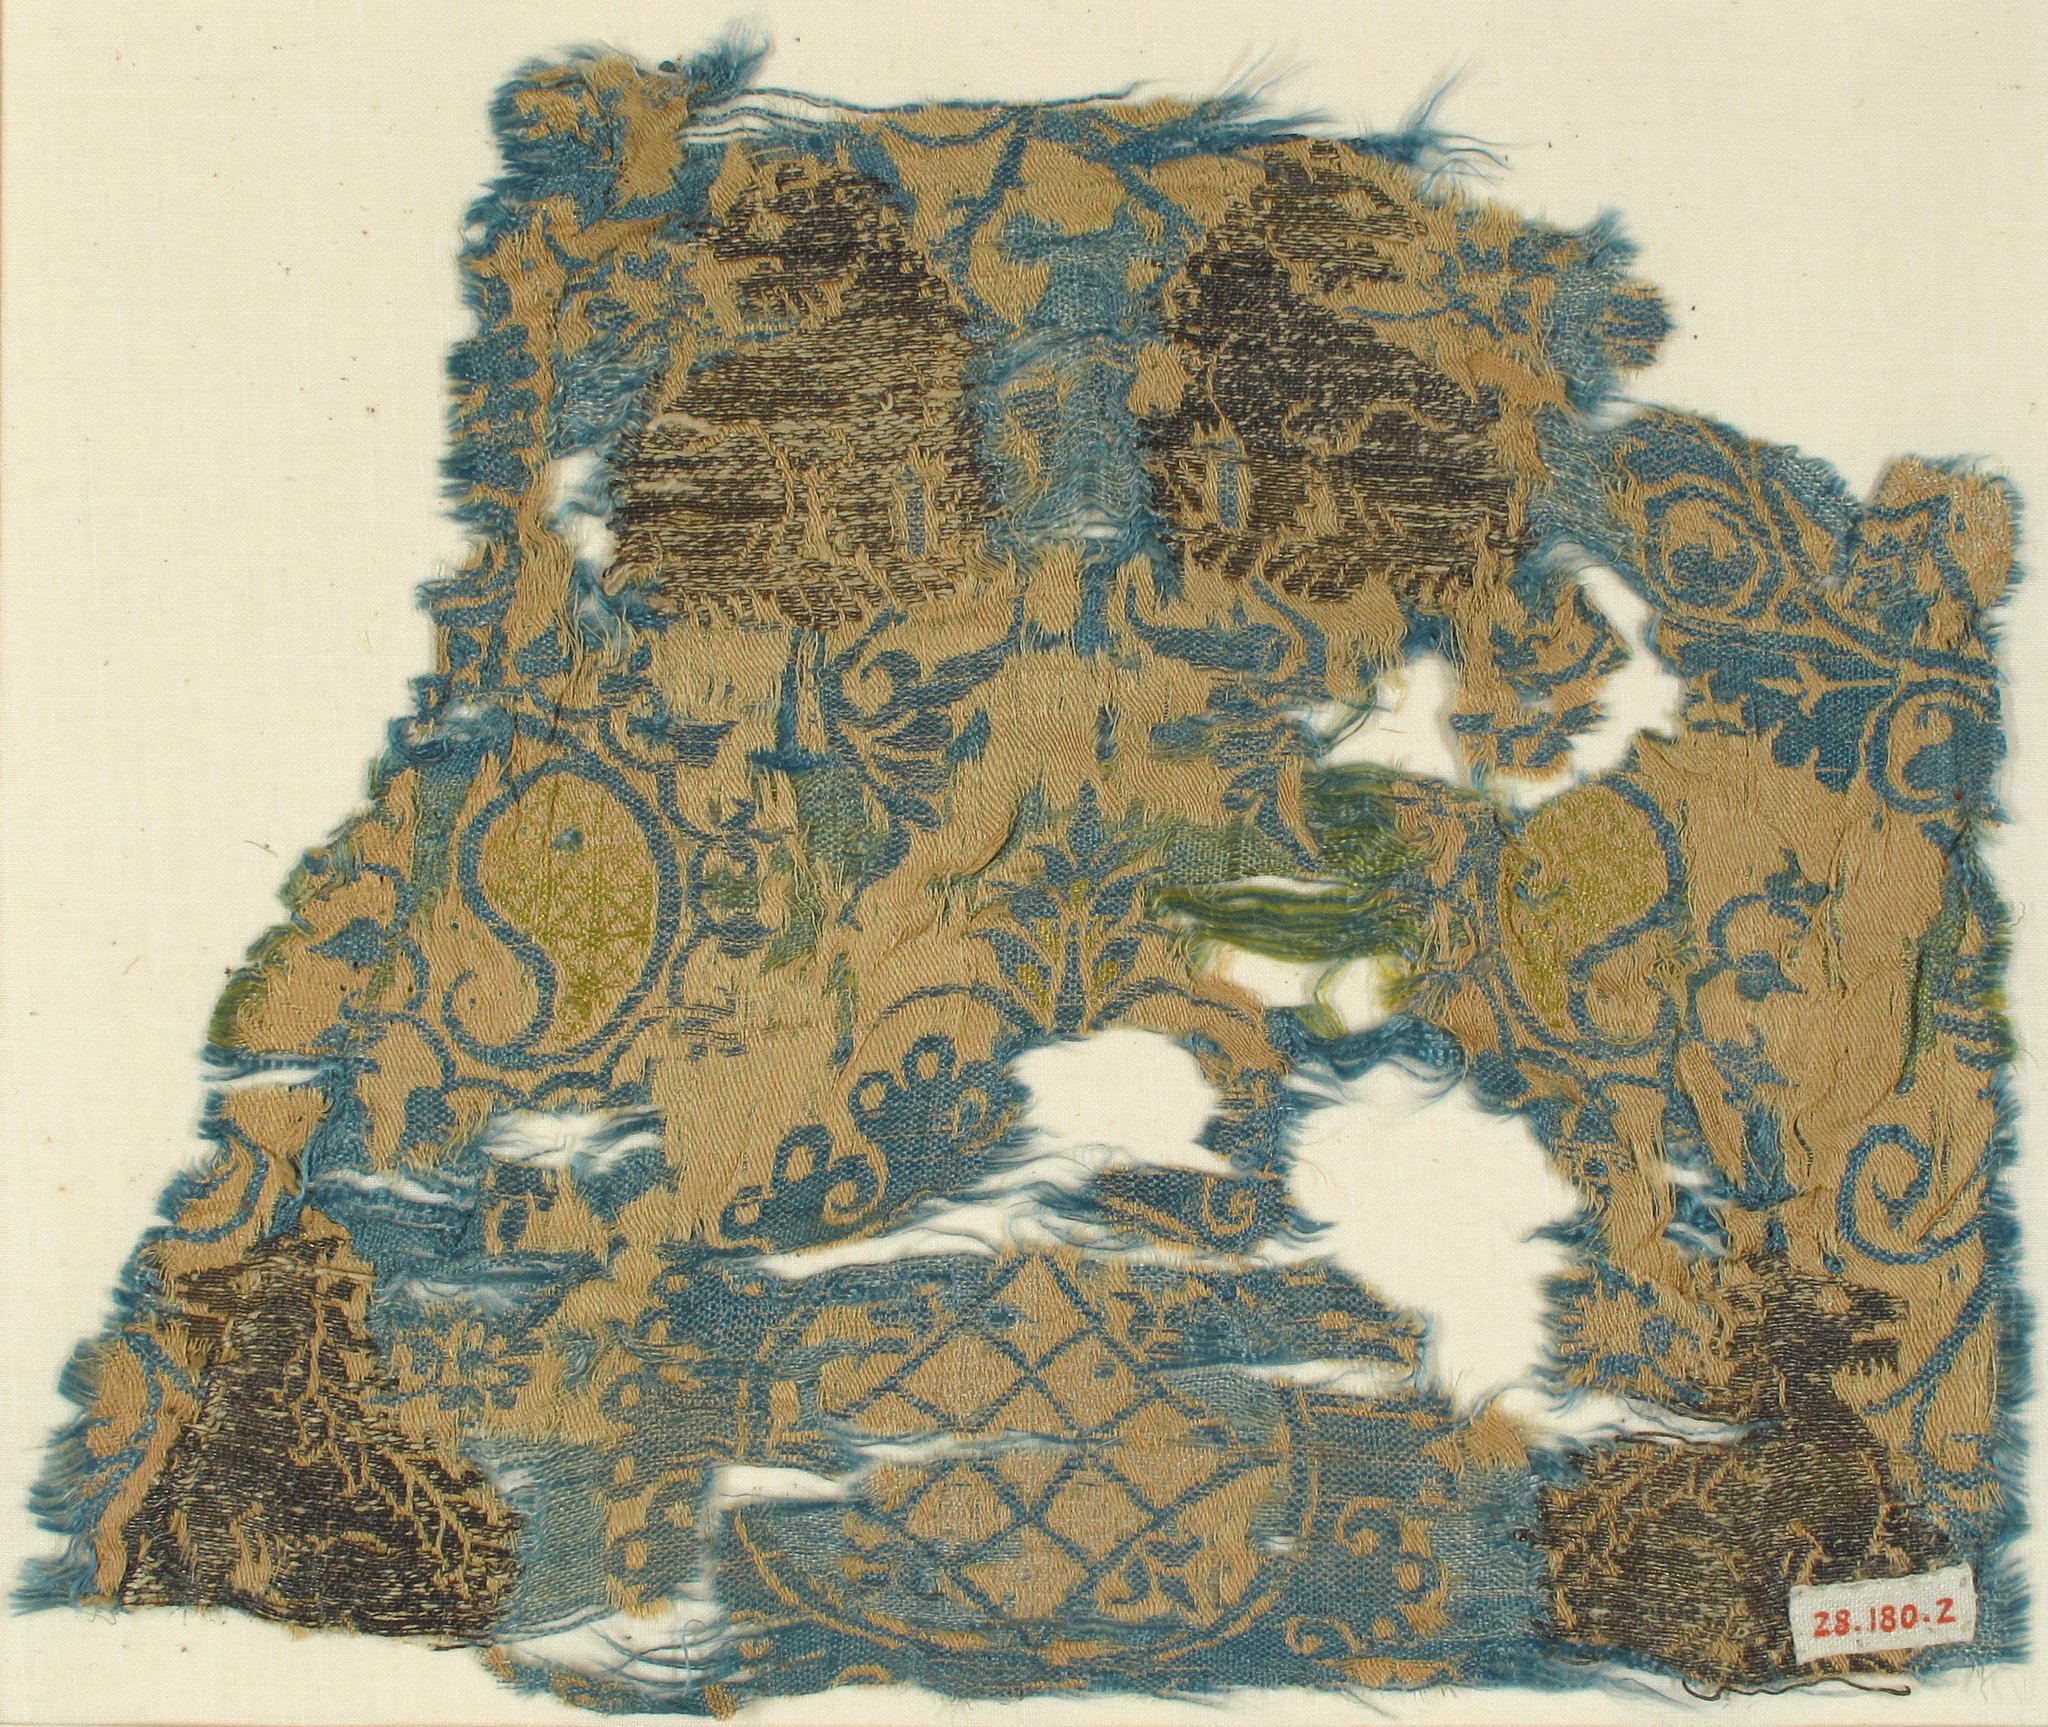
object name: textile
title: Brocade Textile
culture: north italian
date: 1301-1400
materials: metal thread, silk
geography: italy